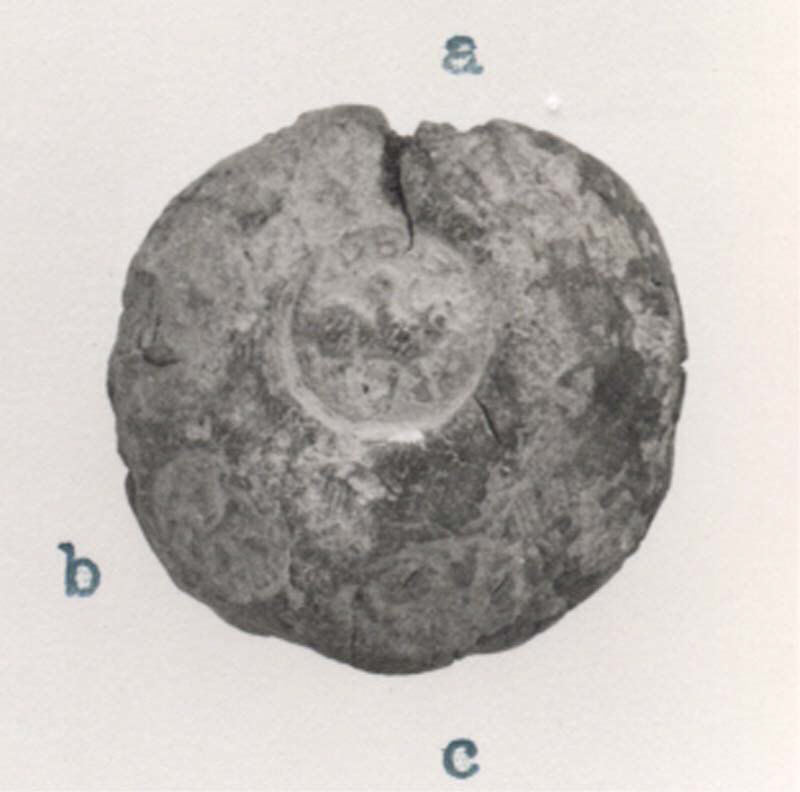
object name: sealing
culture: sasanian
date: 601-700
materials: clay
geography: iran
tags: animals